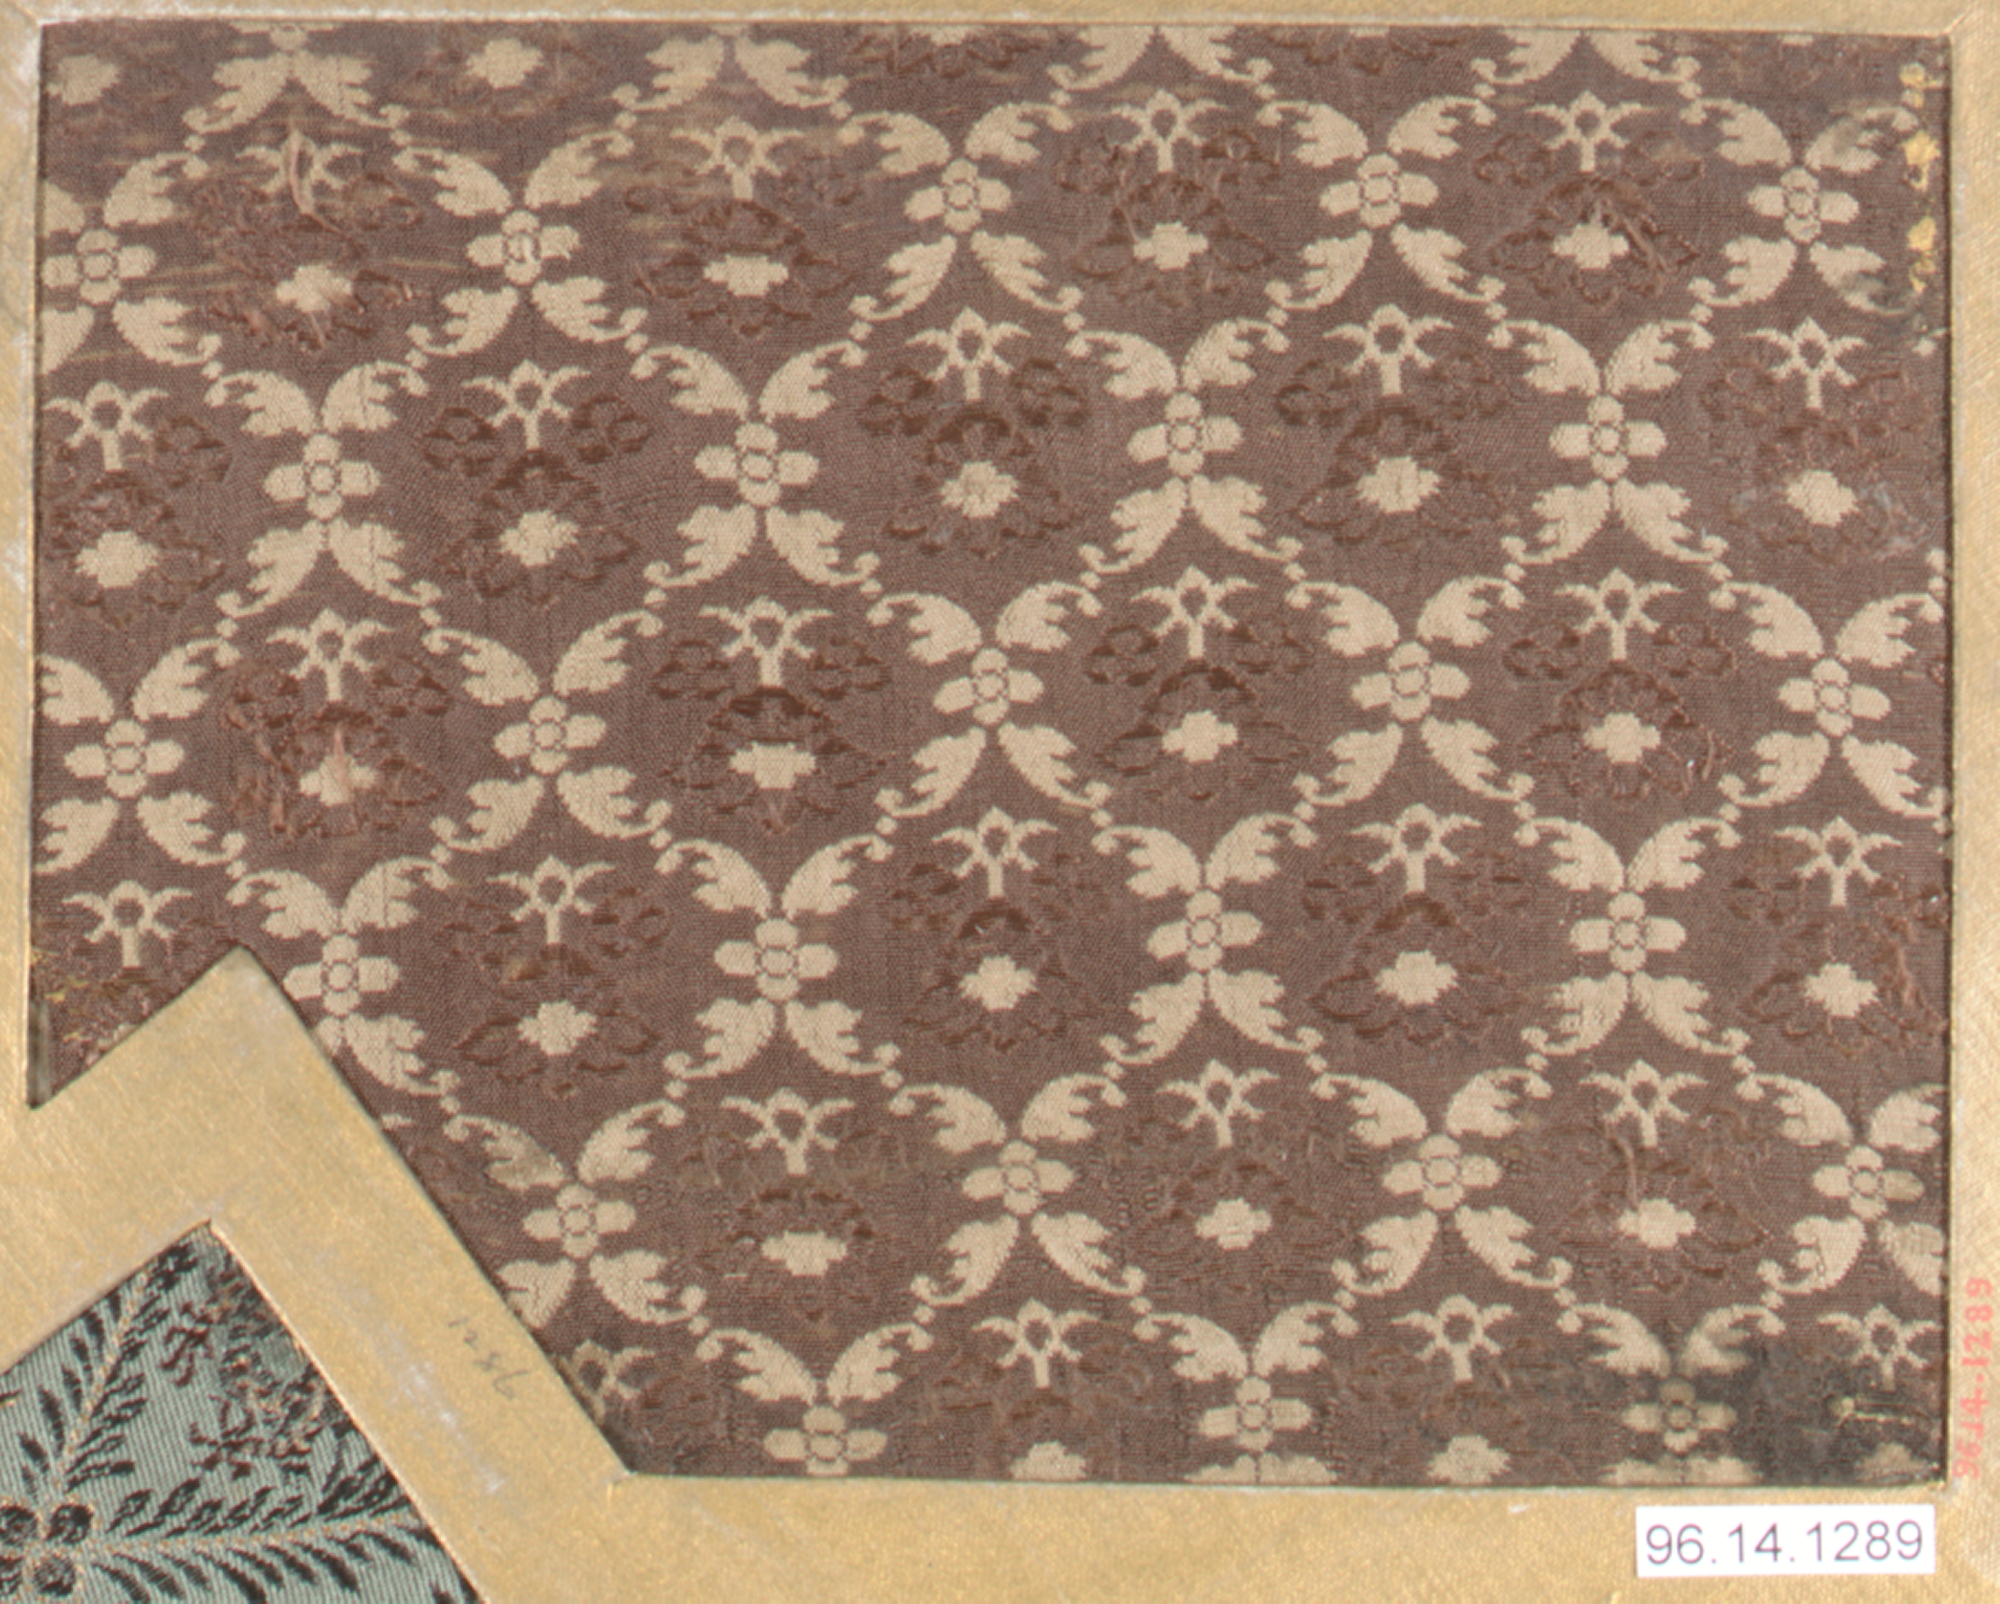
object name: piece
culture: japanese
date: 1701-1900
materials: silk